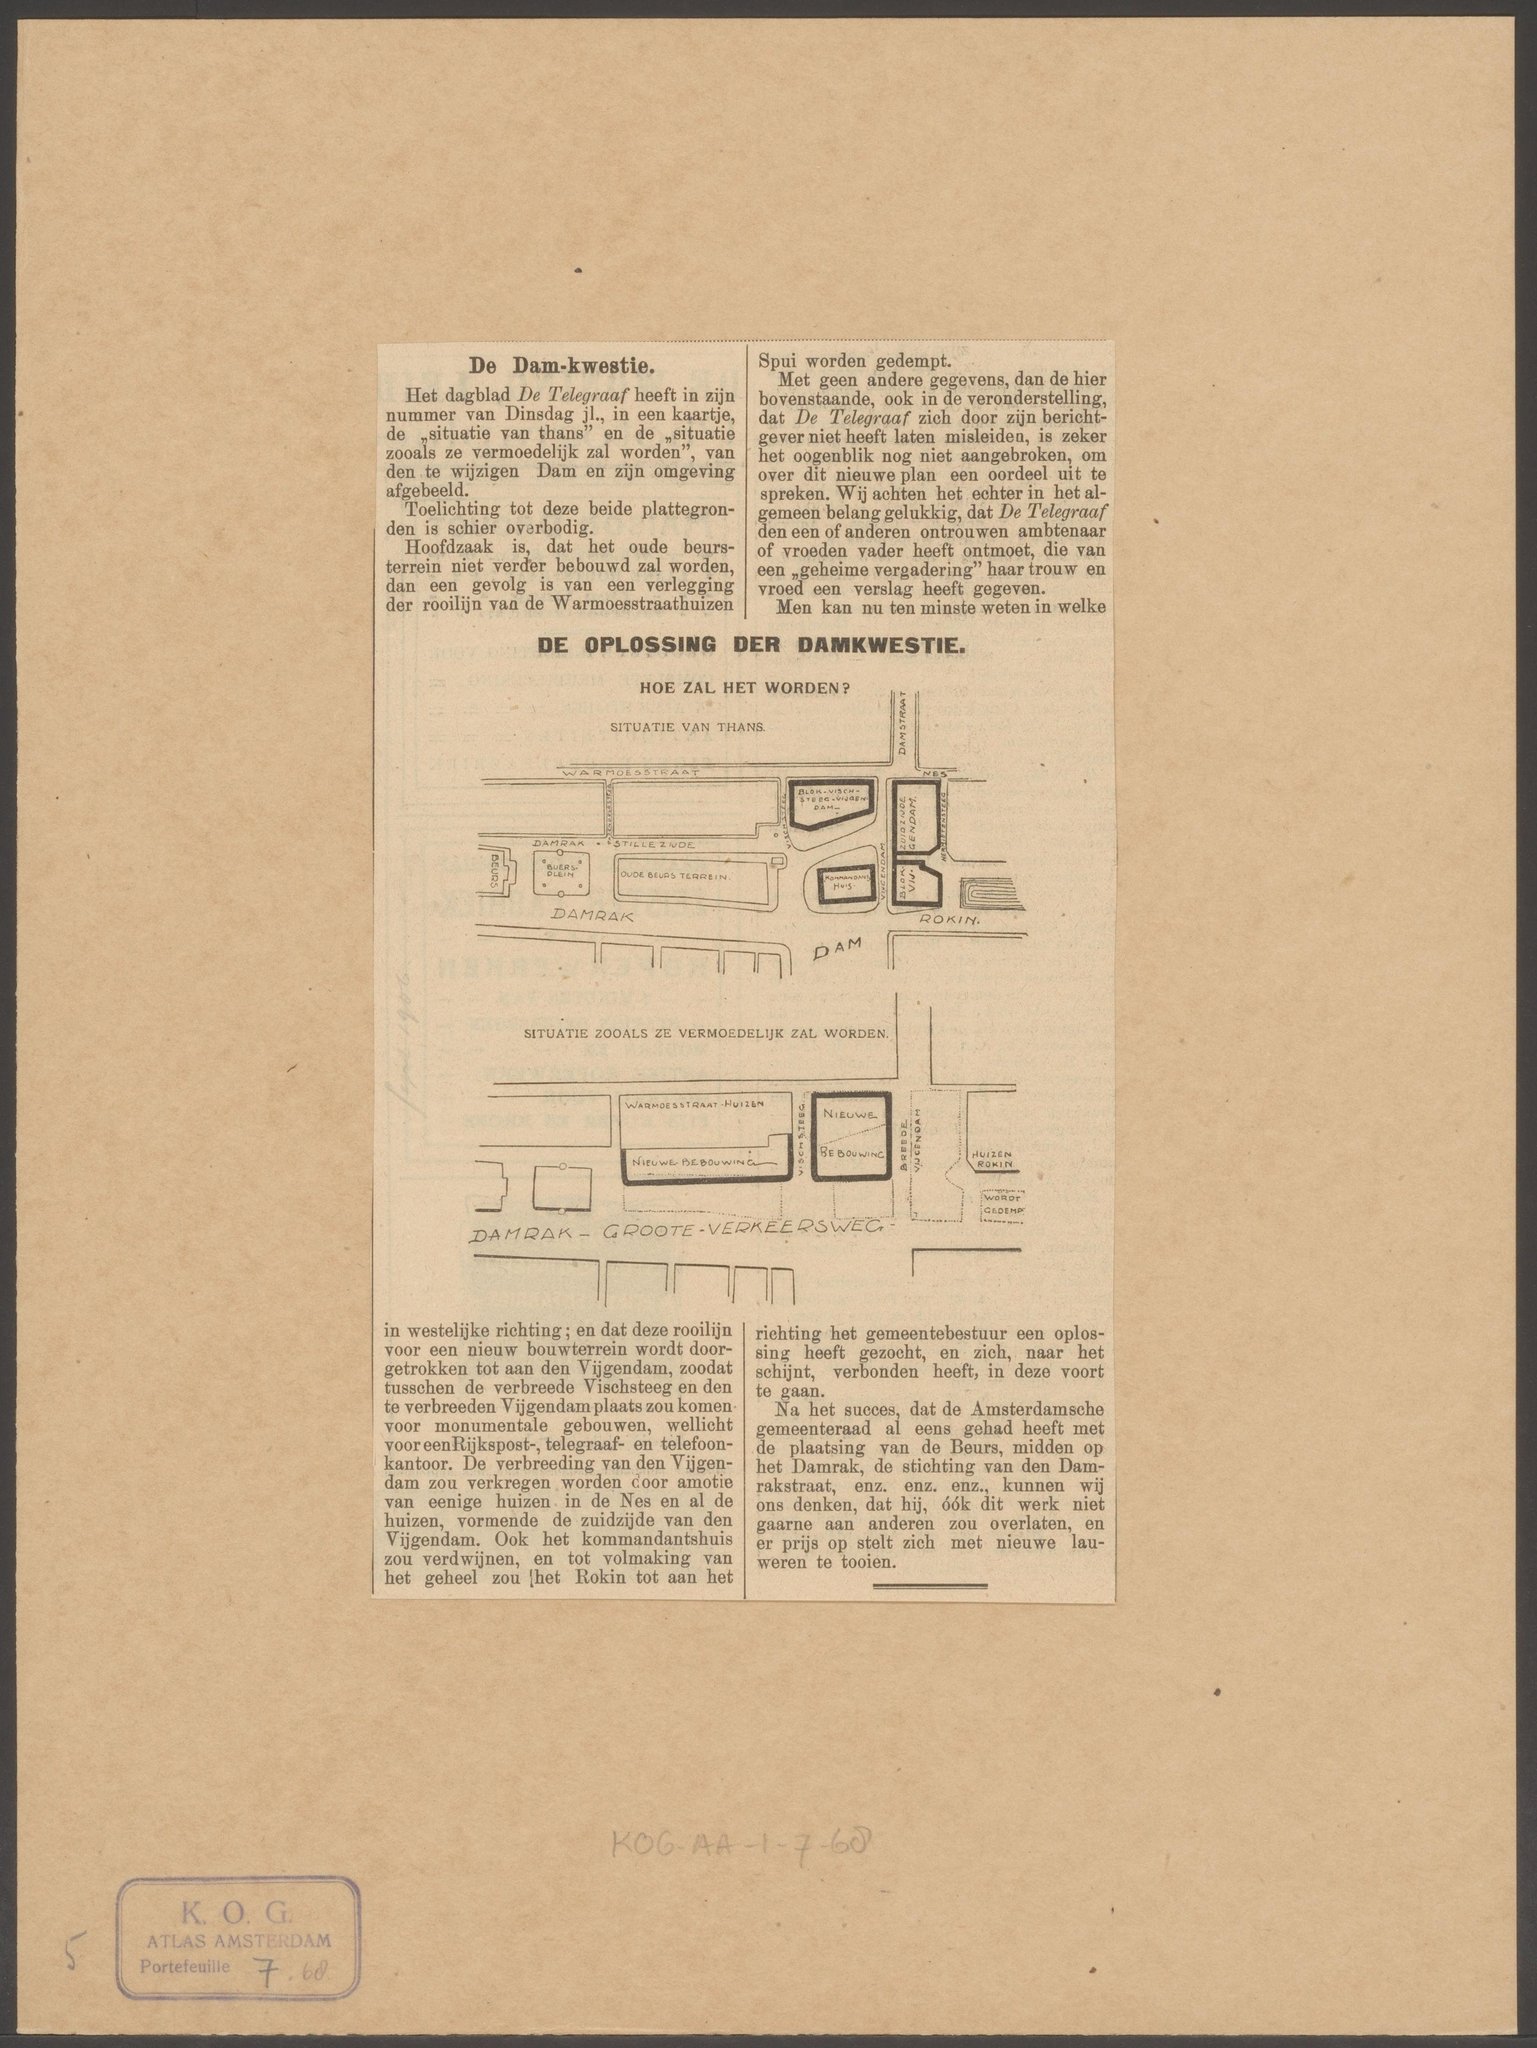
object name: newspaper clipping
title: Plattegrond van de Dam en de plannen voor de verbouwing van de Dam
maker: Anonymous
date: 1900-1912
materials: paper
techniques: letterpress printing, line block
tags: square, place, circus, etc., city-view in general; 'veduta', maps of cities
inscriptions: collector's mark: ‘7’ Lugt 1641b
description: Fotomechanische afdruk uit een editie van: De Amsterdammer tussen 1900 en 1912.